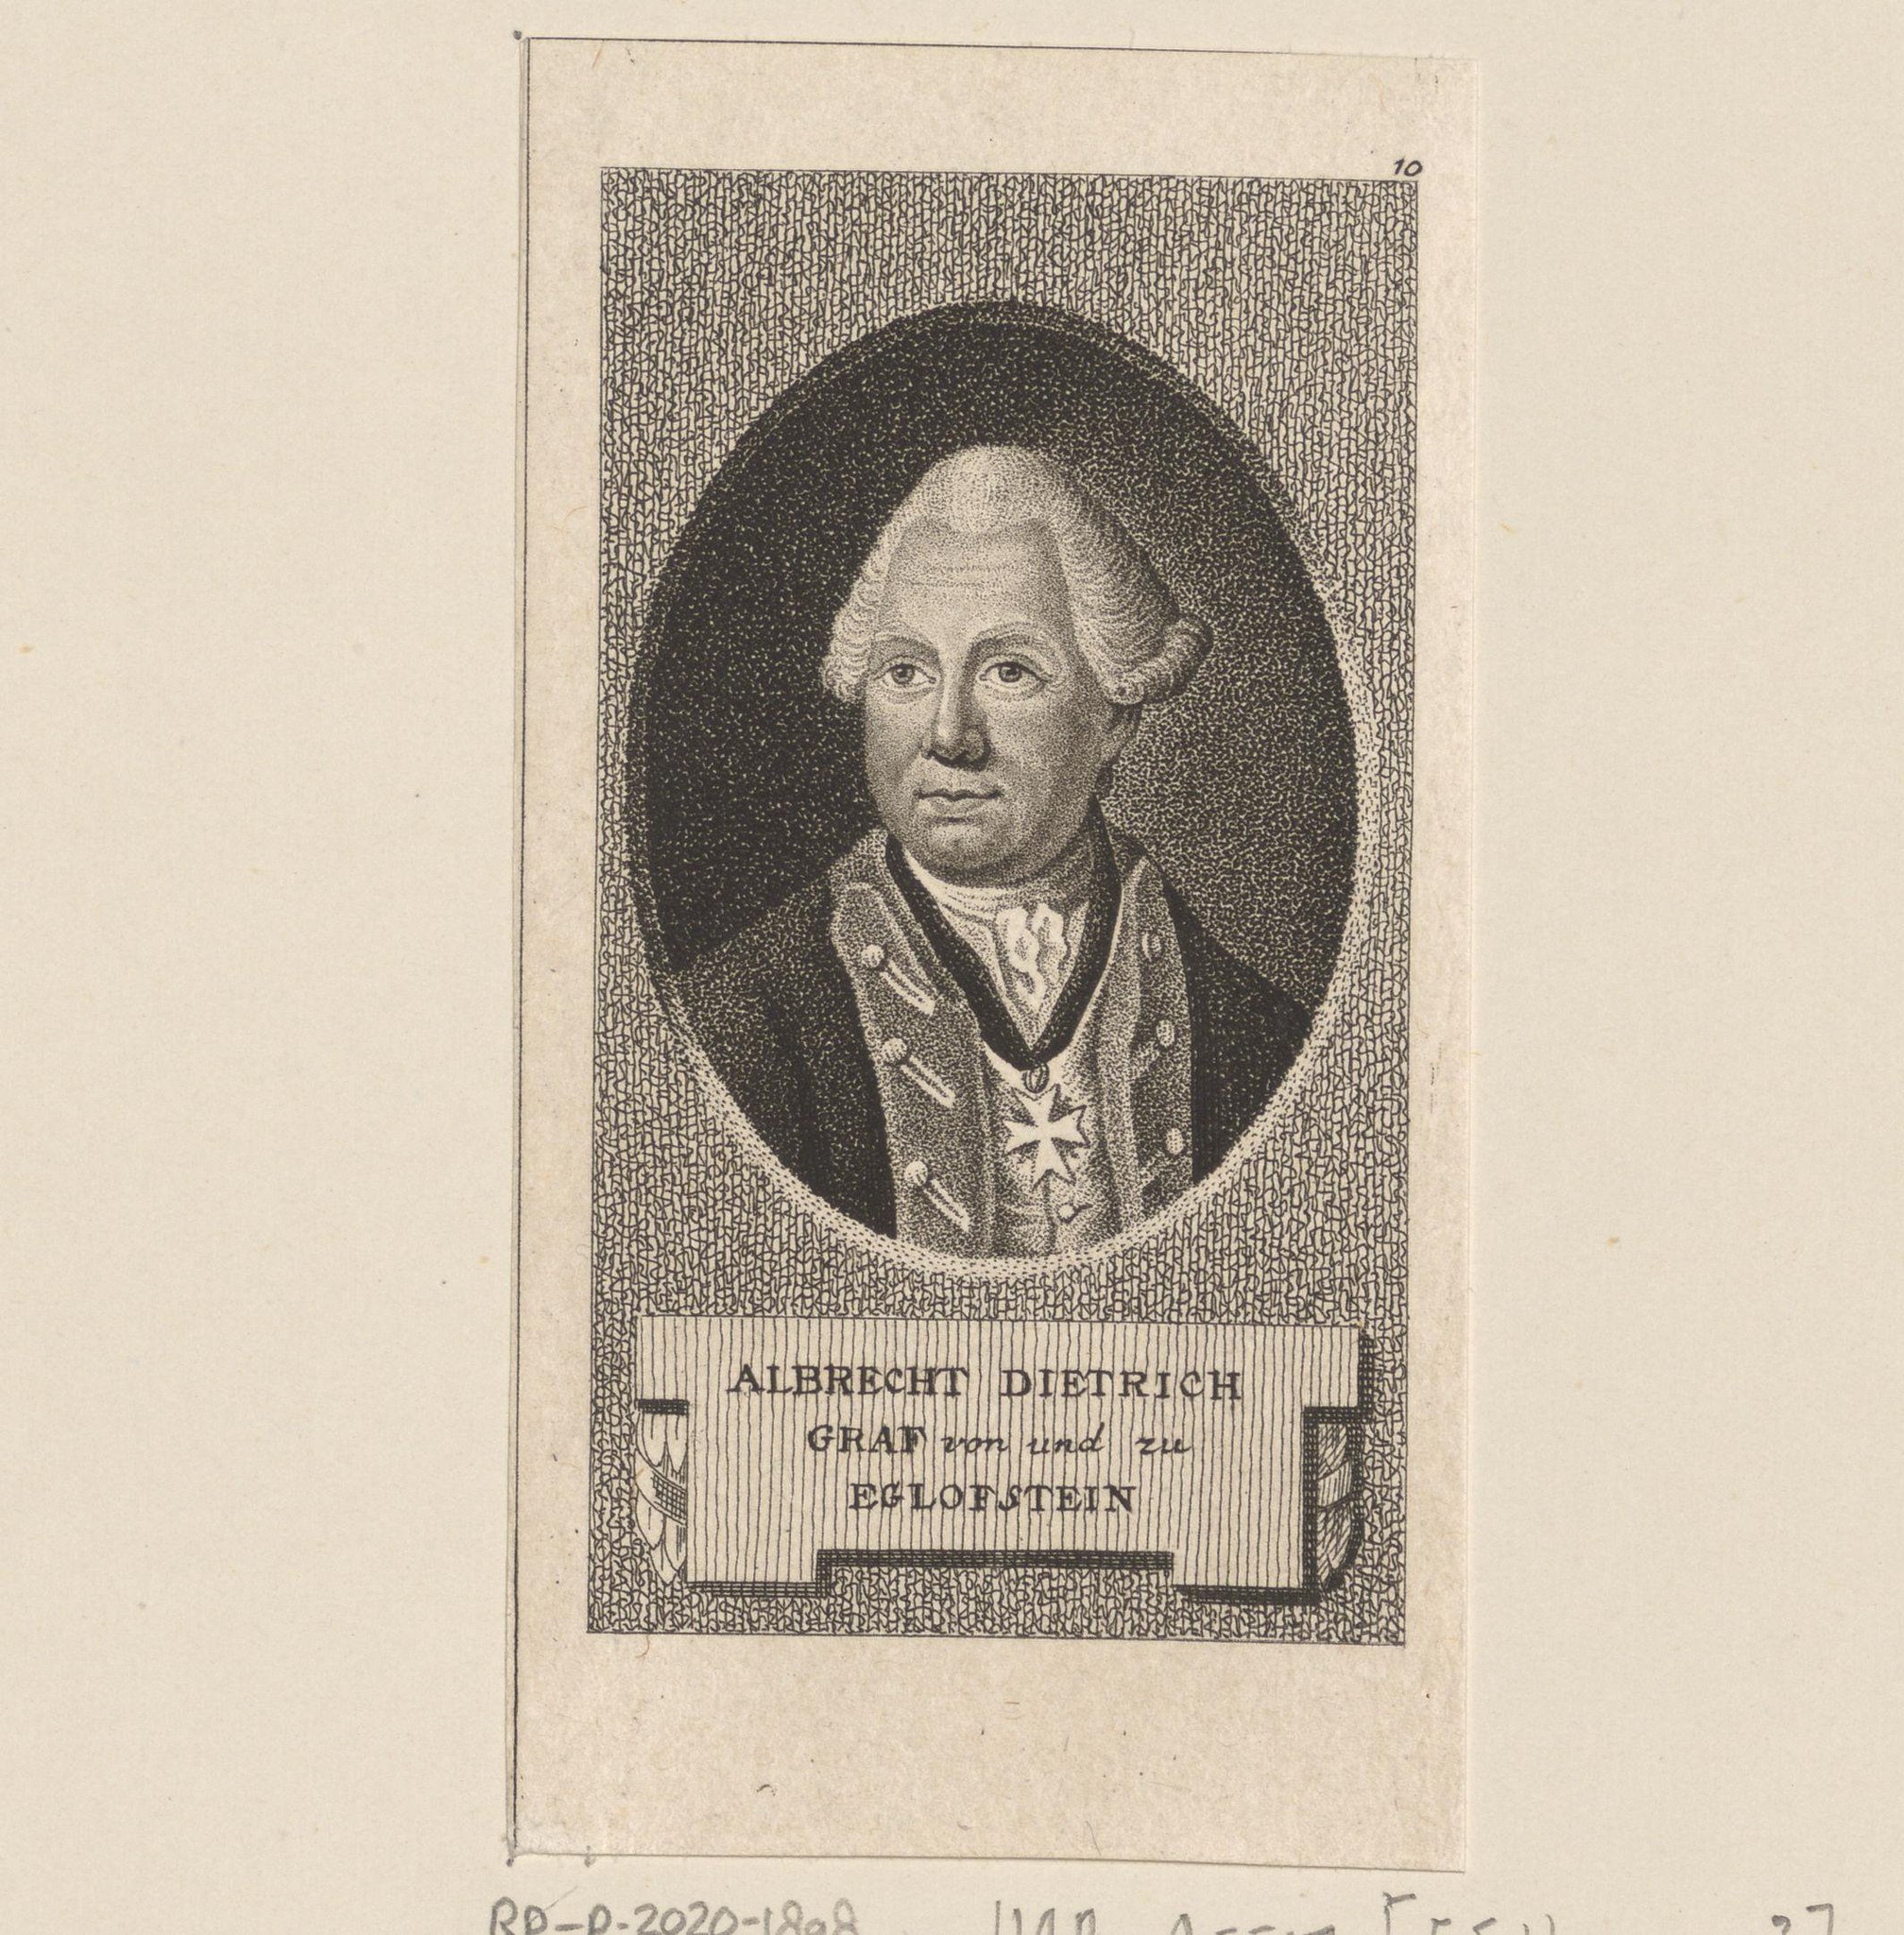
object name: print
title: Portret van Albrecht Dietrich von Egloffstein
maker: eberhard siegfried henne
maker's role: print maker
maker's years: 1759-1828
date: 1770-1800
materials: paper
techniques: etching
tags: historical persons